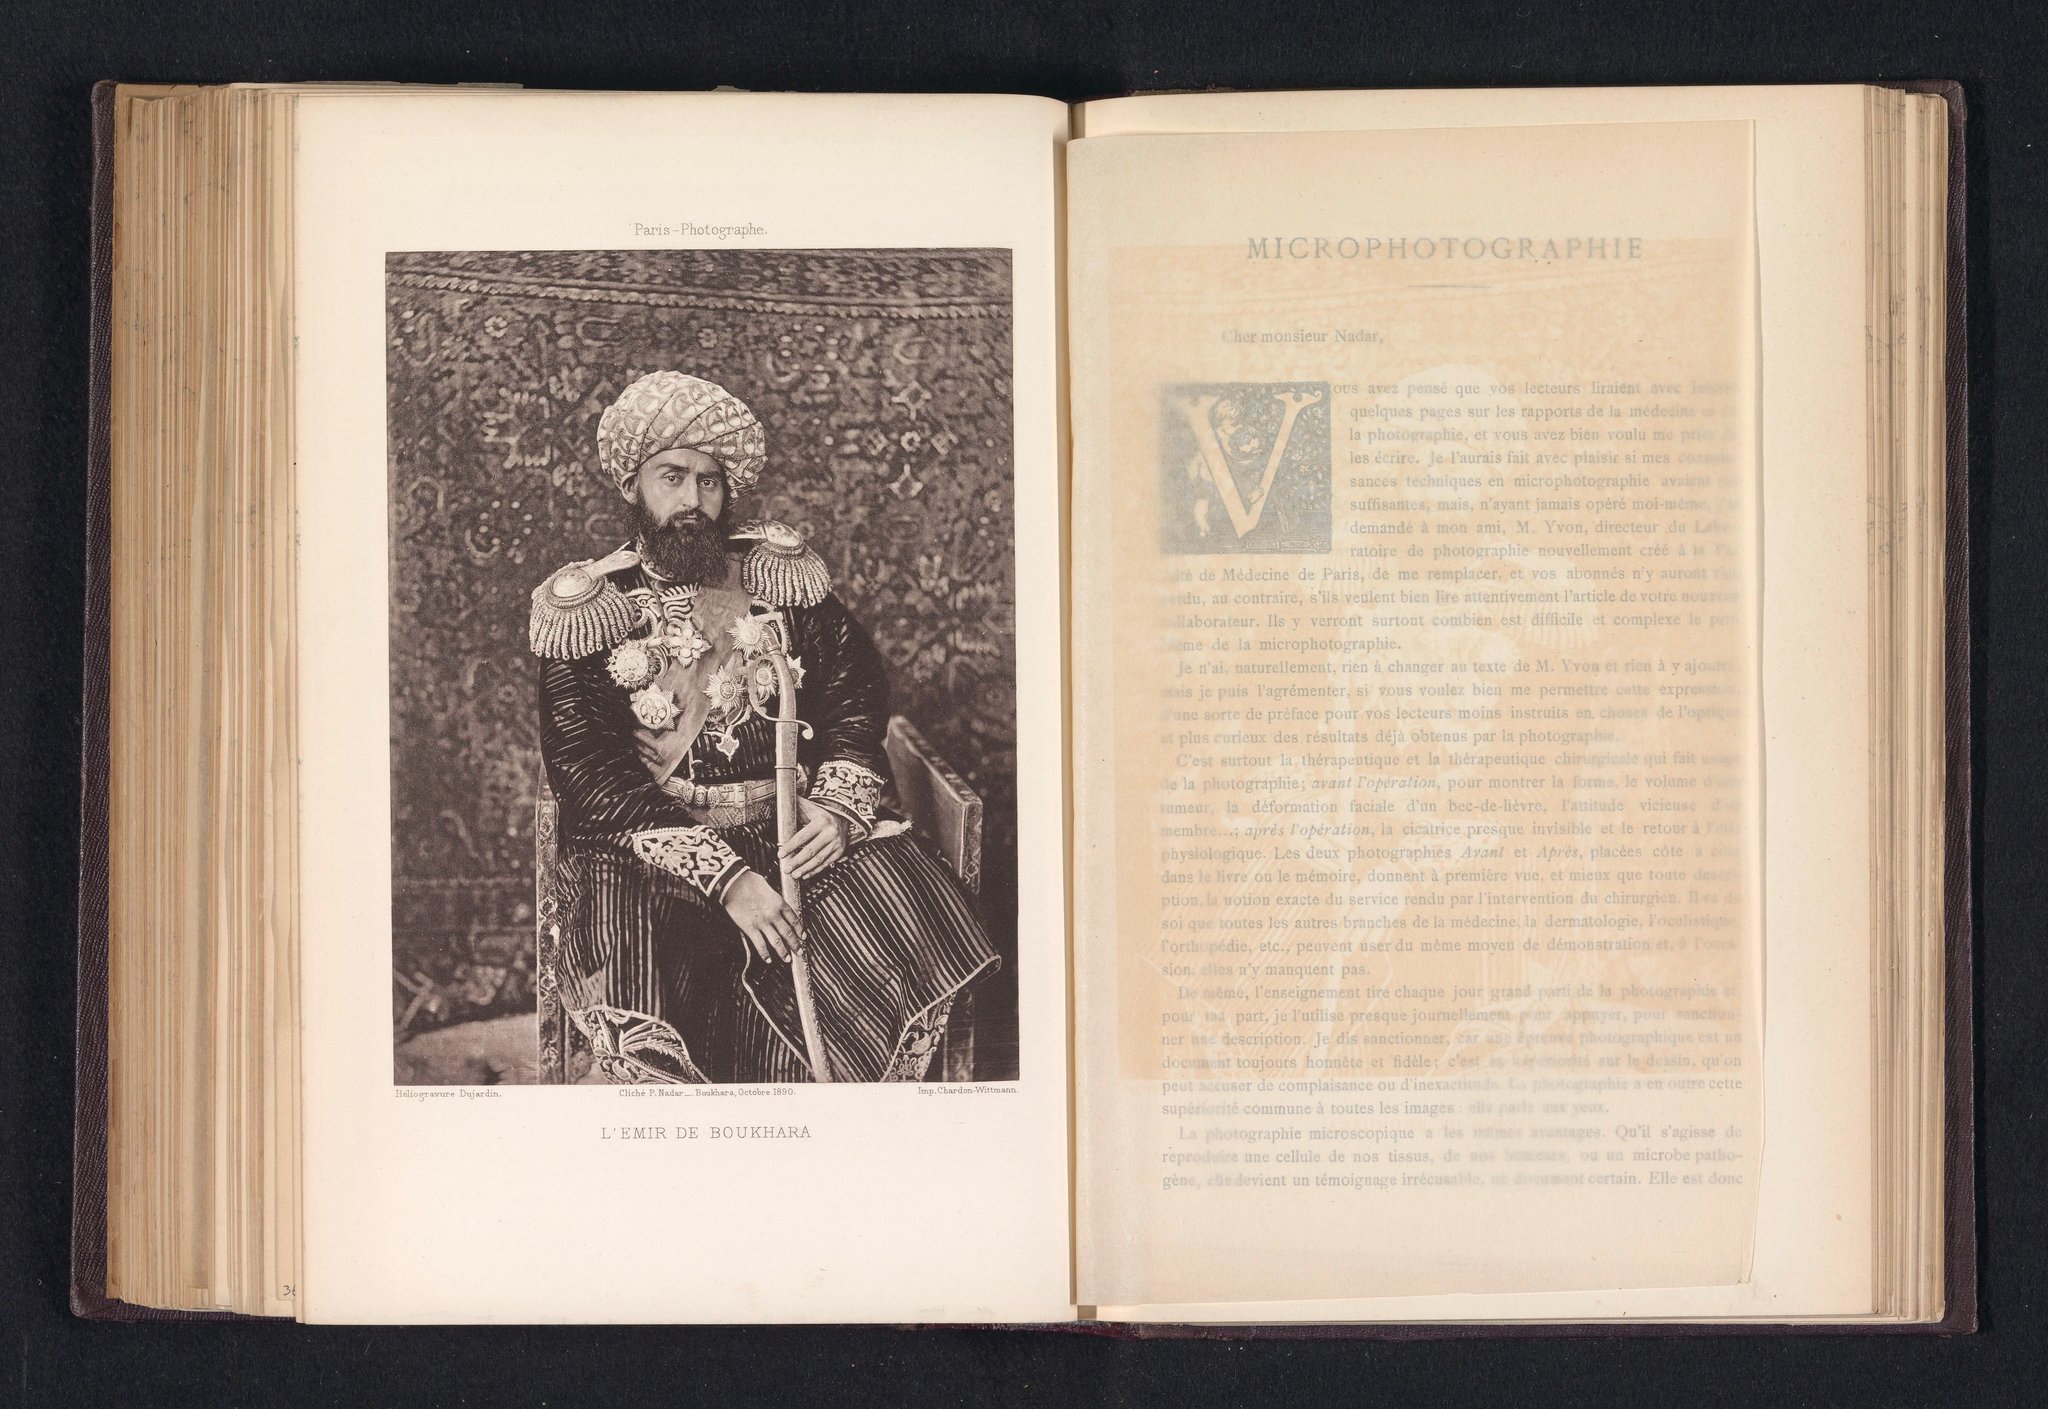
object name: page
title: Portret van de emir van Buchara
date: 1810-1890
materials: paper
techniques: photoaquatint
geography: france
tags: head-gear: turban, ruler, sovereign